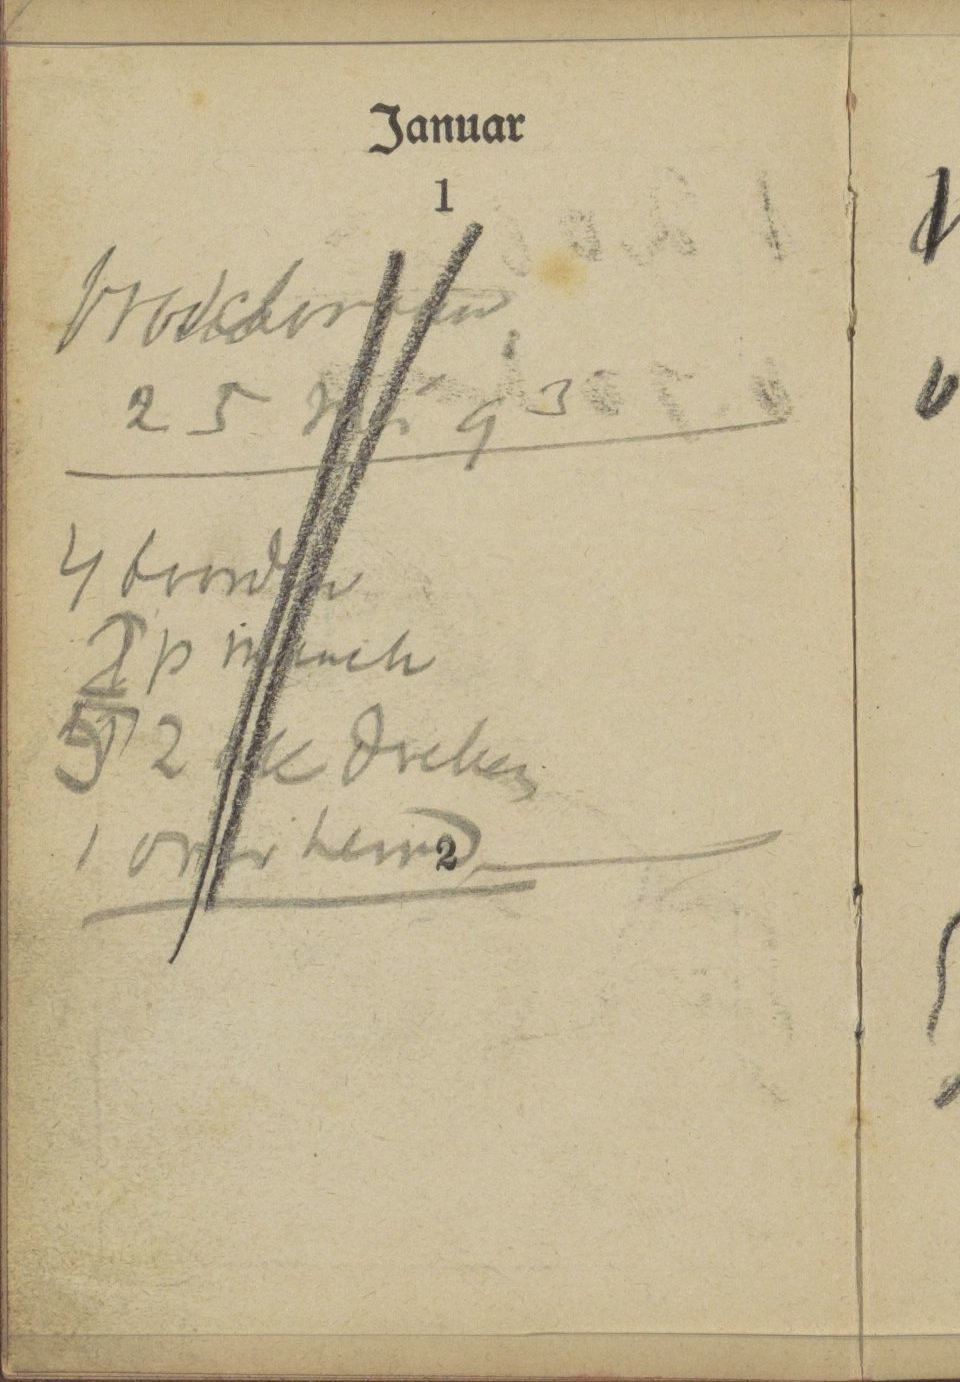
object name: sketchbook leaf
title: Annotaties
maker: george hendrik breitner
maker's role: draughtsman, painter, print maker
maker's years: 1857-1923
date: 1893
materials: chalk, paper, pencil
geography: amsterdam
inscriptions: annotation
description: Pagina 5 uit een als schetsboek gebruikte agenda met 80 bladen.